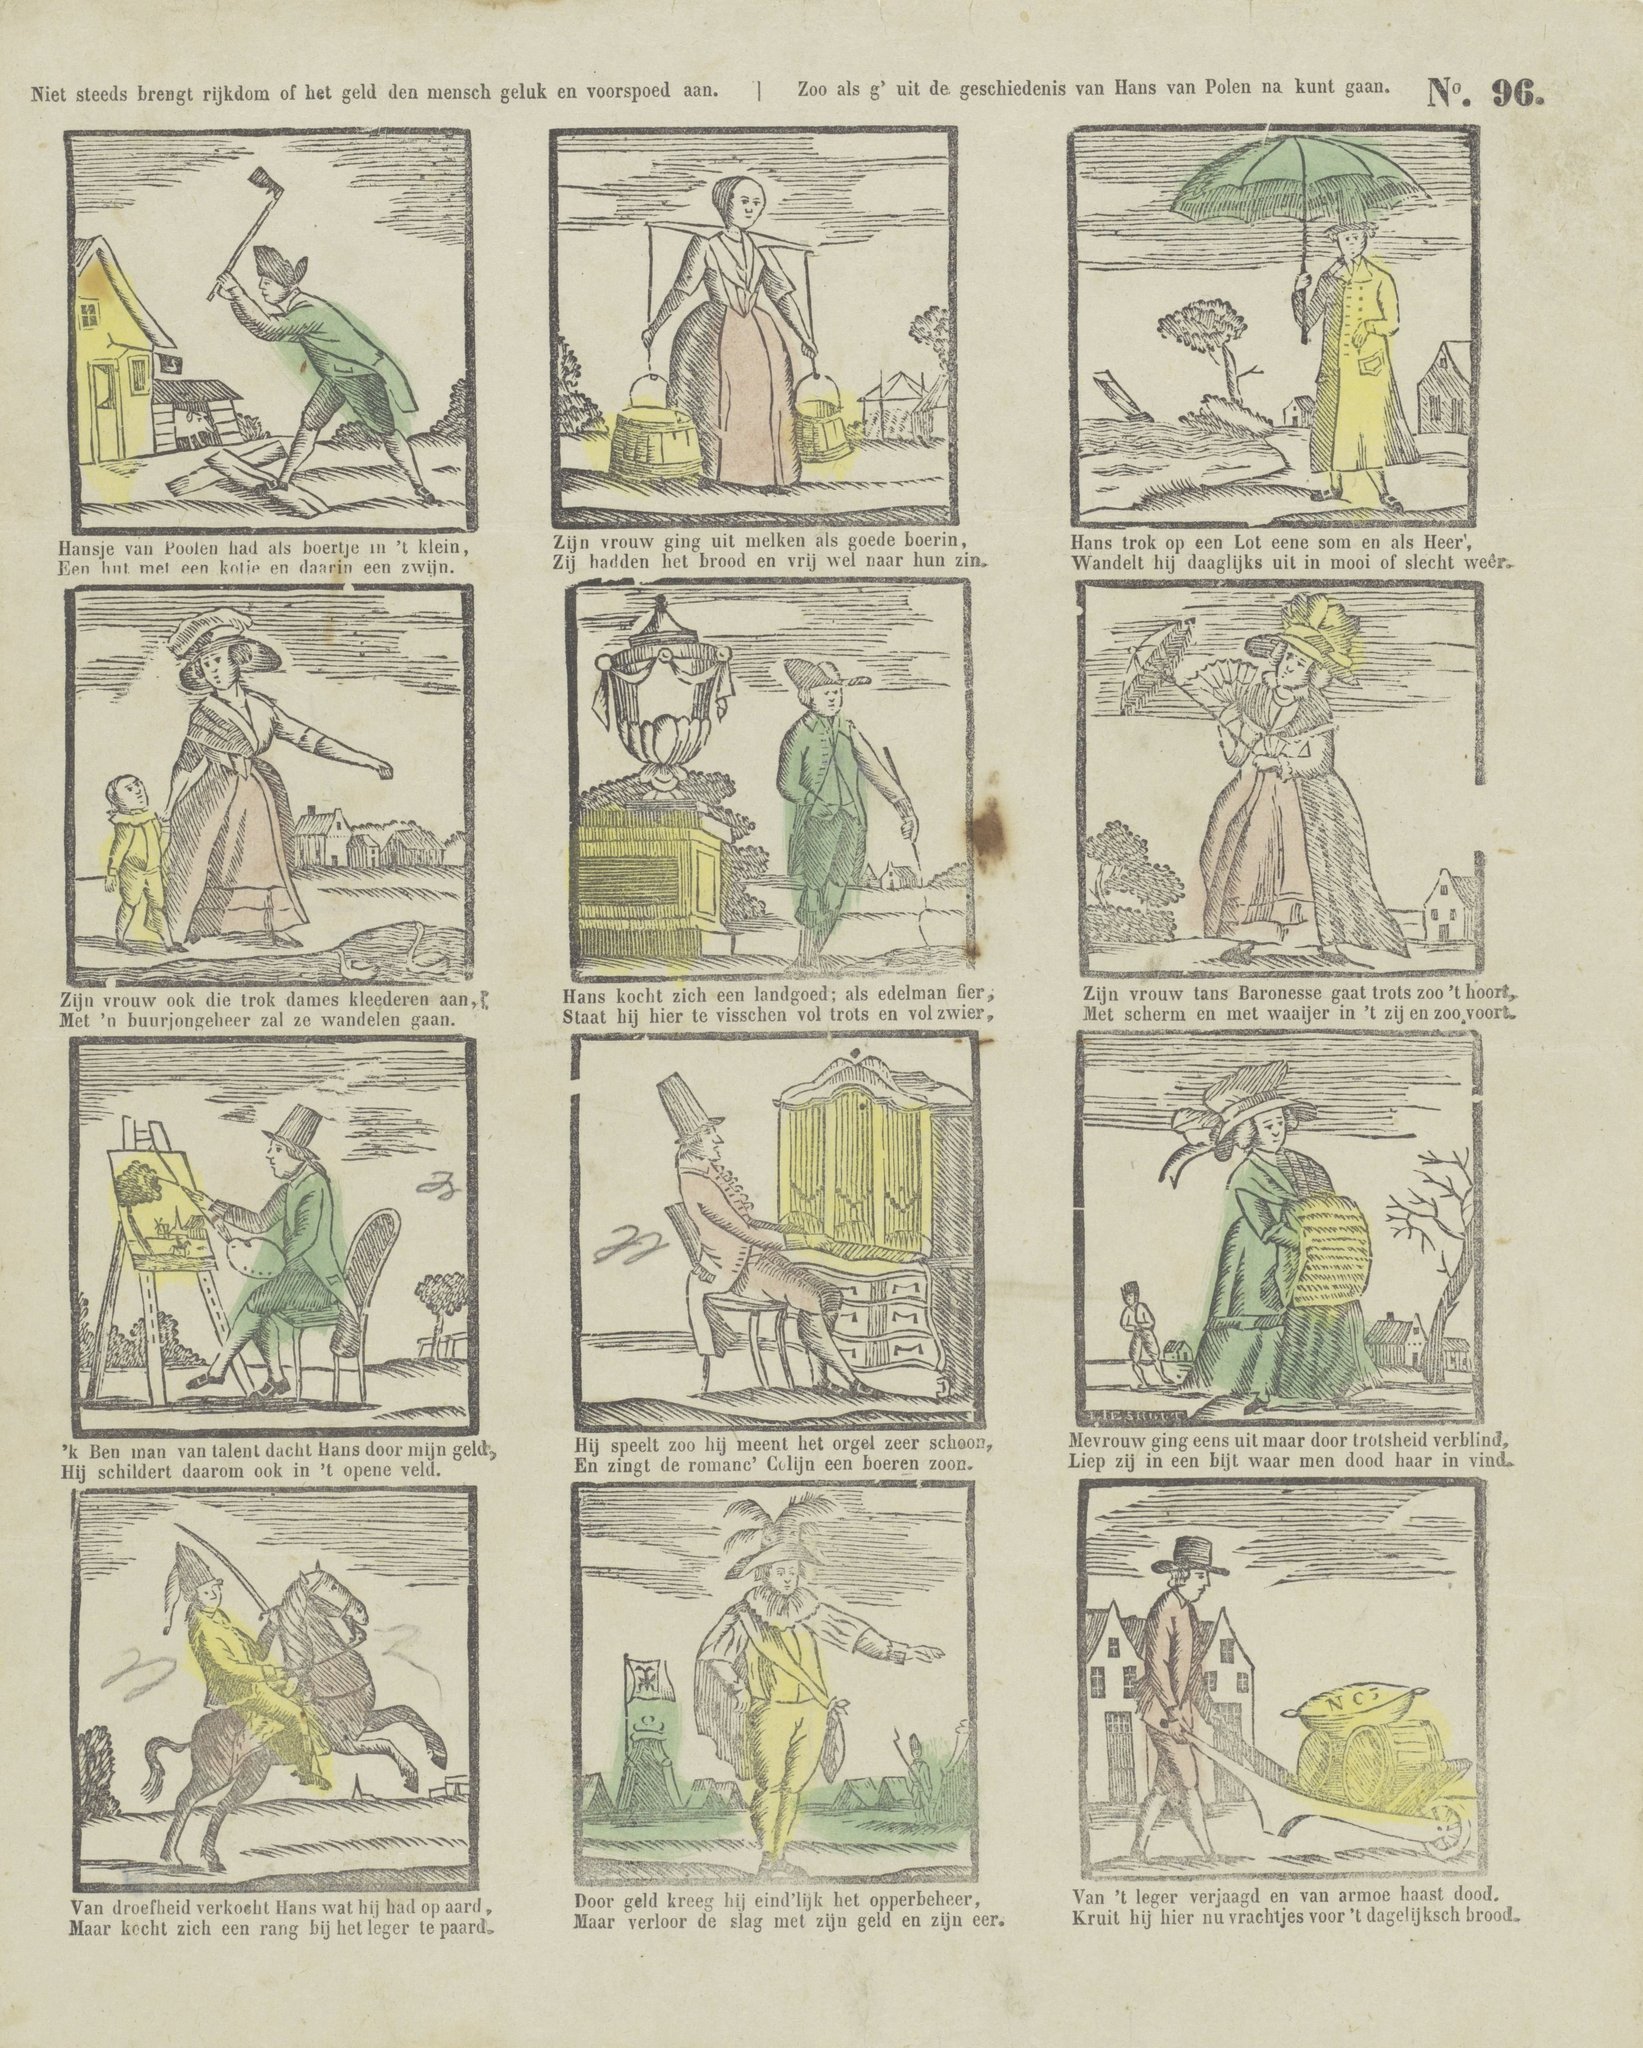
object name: print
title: Niet steeds brengt rijkdom of het geld den mensch geluk en voorspoed aan, / Zoo als g' uit de geschiedenis van Hans van Polen na kunt gaan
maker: johannes egbertus van lieshout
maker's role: print maker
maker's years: 1770-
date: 1850-1870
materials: paper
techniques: colour, letterpress printing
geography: netherlands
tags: organ, contrast between rich and poor, warfare; military affairs (+ cavalry, horsemen), tales and fairy tales, milkmaid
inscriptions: collector's mark: Lugt 2760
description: Blad met 12 voorstellingen uit het leven van Hans van Polen. Onder elke afbeelding een tweeregelig vers. Genummerd rechtsboven: No. 96.